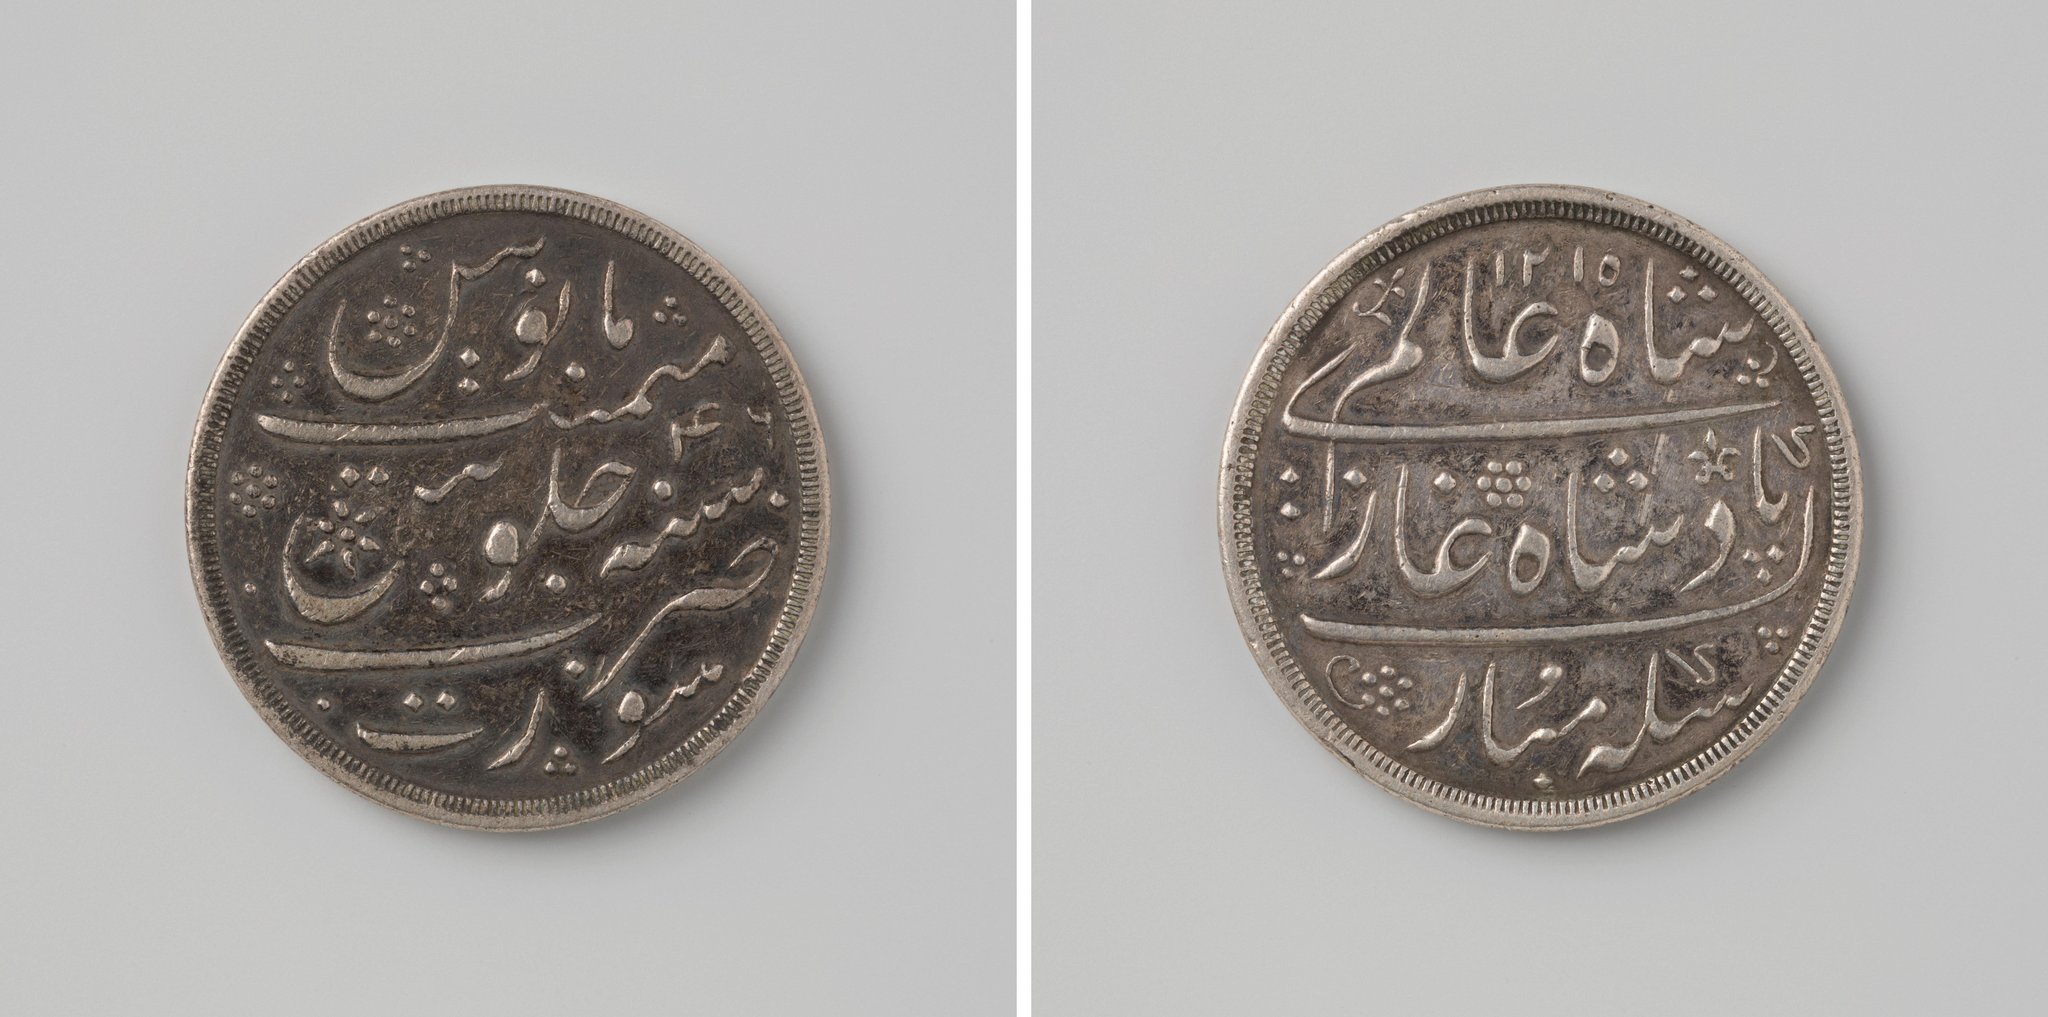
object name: coin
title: Surat-roepie uit Bombay in India van de Engelse Oostindische Compagnie (EIC), 1215 [=1801]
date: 1832-1835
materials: silver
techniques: striking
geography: mumbai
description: Zilveren munt. Voorzijde: in Arabische lettertekens in drie regels opschrift. Keerzijde: in Arabische lettertekens in drie regels opschrift. Aanduiding jaartal: 1215 [=1801] bovenaan. Geslagen in de jaren 1832-1835 te Bombay. Gladde rand.